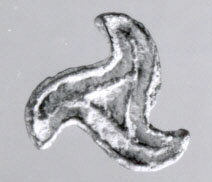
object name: stamp seal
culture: bactria-margiana archaeological complex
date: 2333-1668 BCE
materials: copper alloy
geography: bactria-margiana